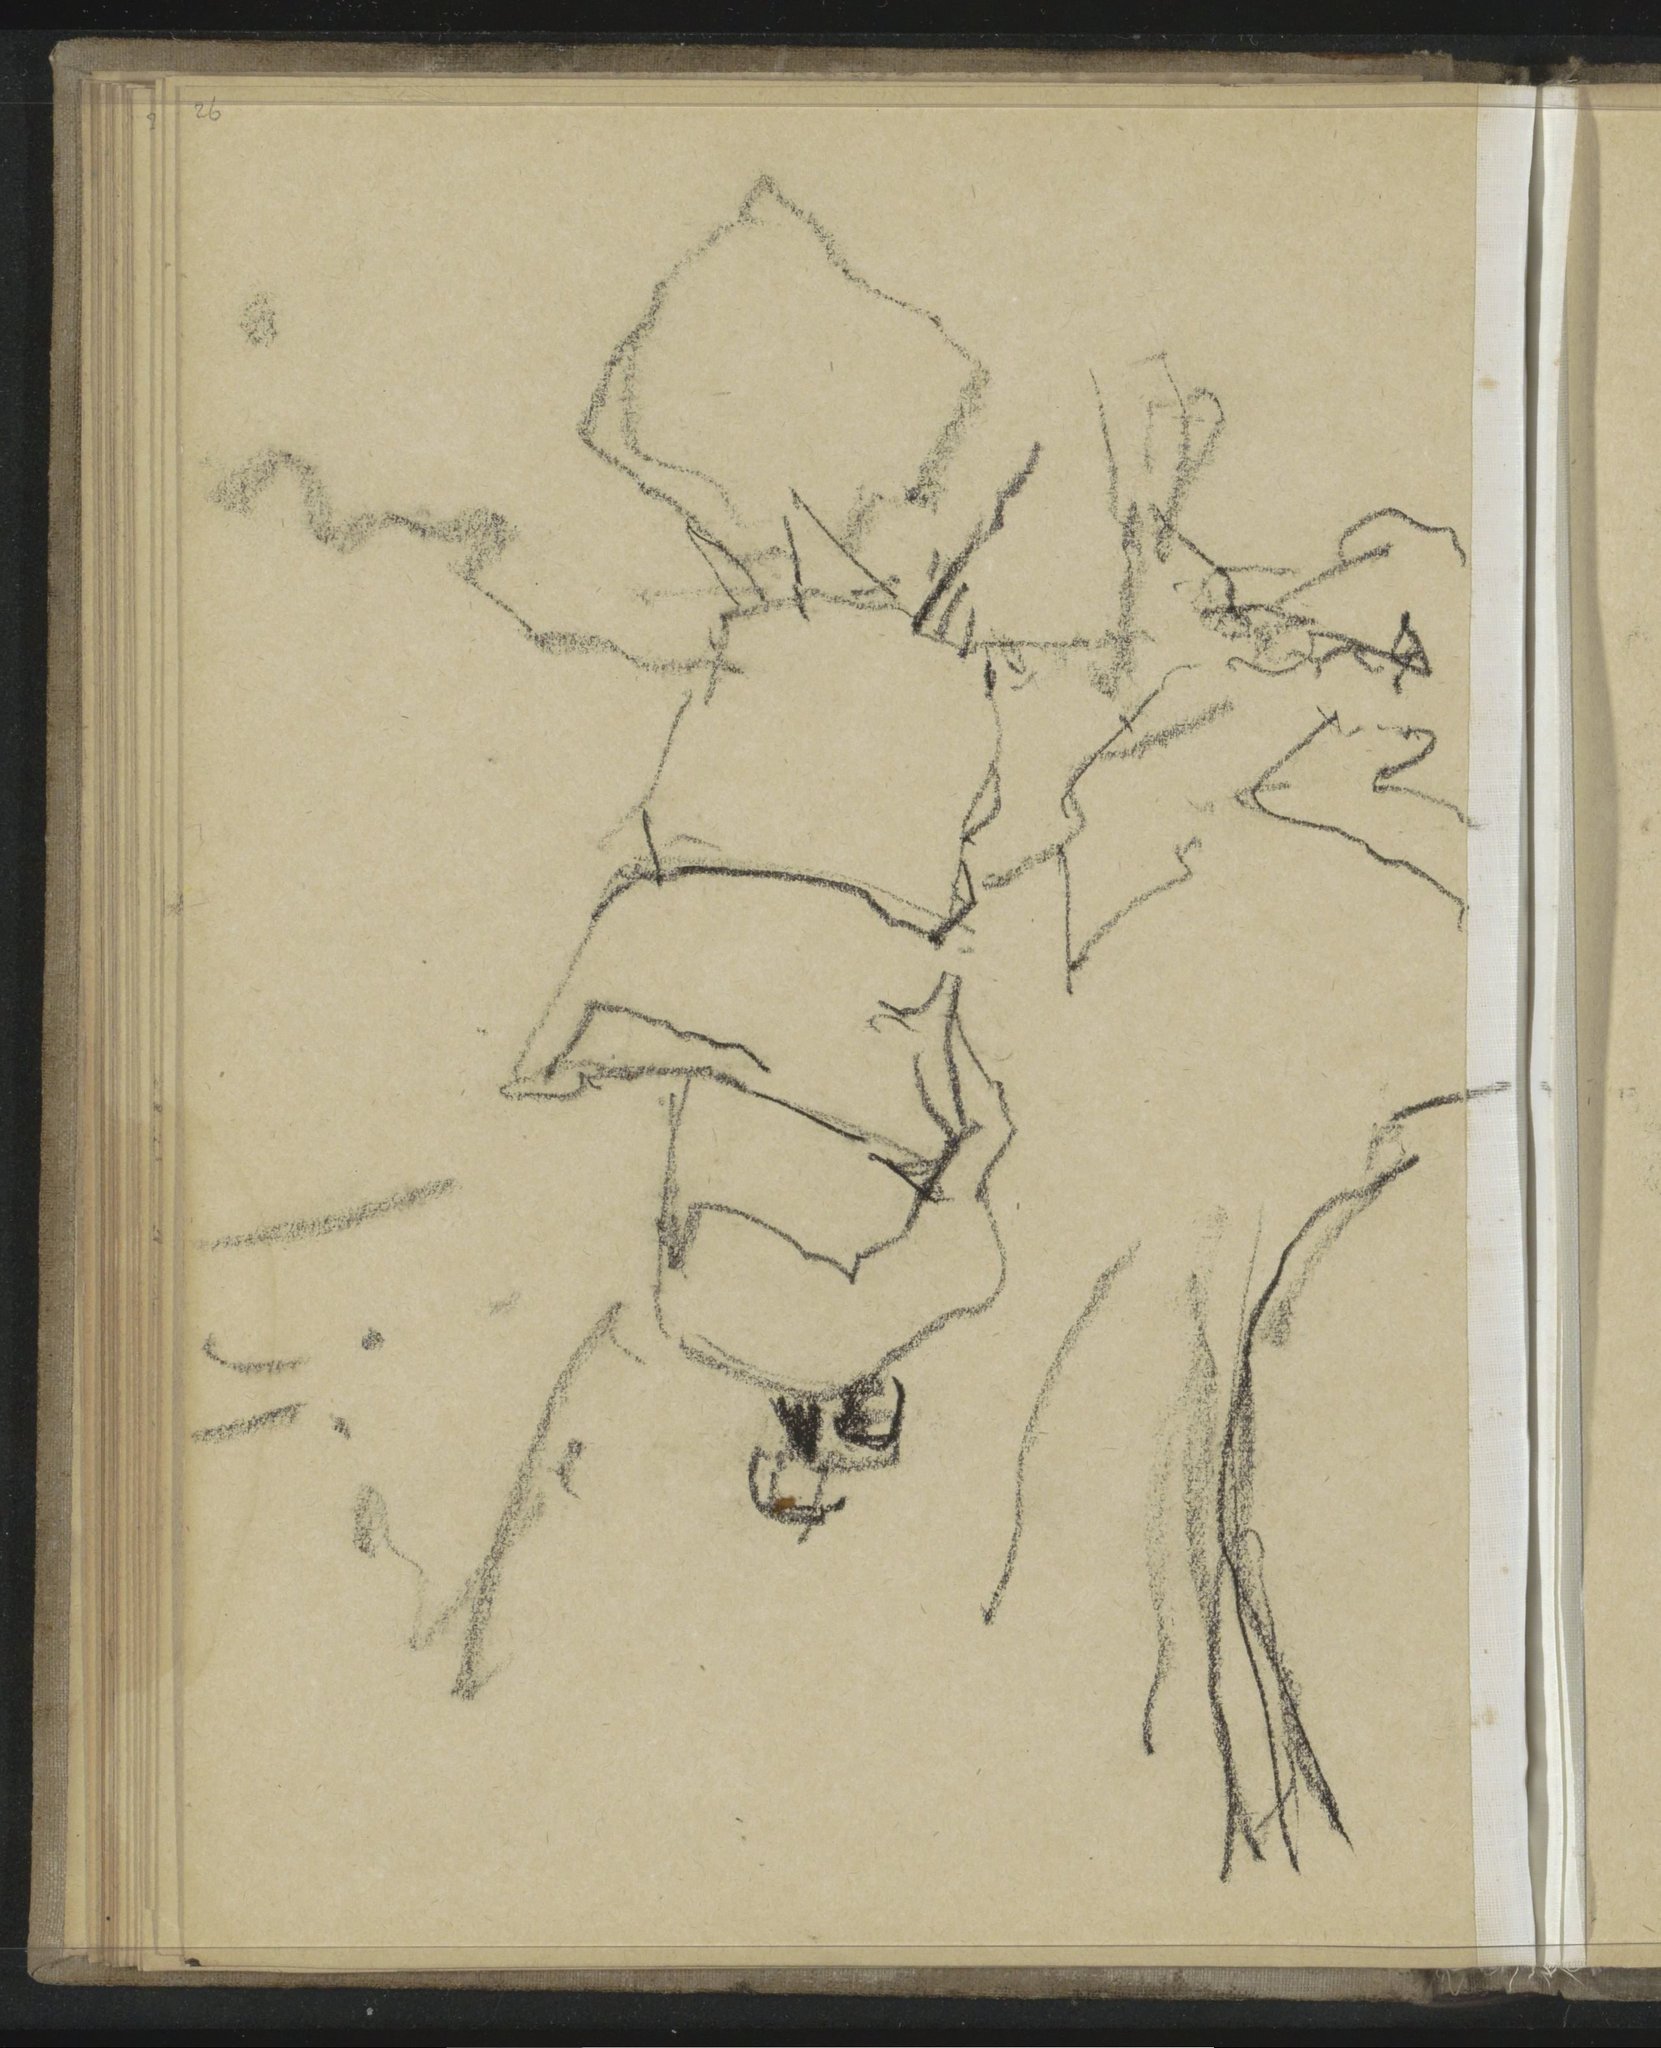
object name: sketchbook leaf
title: Studie, mogelijk van een landschap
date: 1892-1897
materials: chalk, paper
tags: landscapes in the temperate zone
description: Pagina 26 uit een schetsboek met 24 bladen.